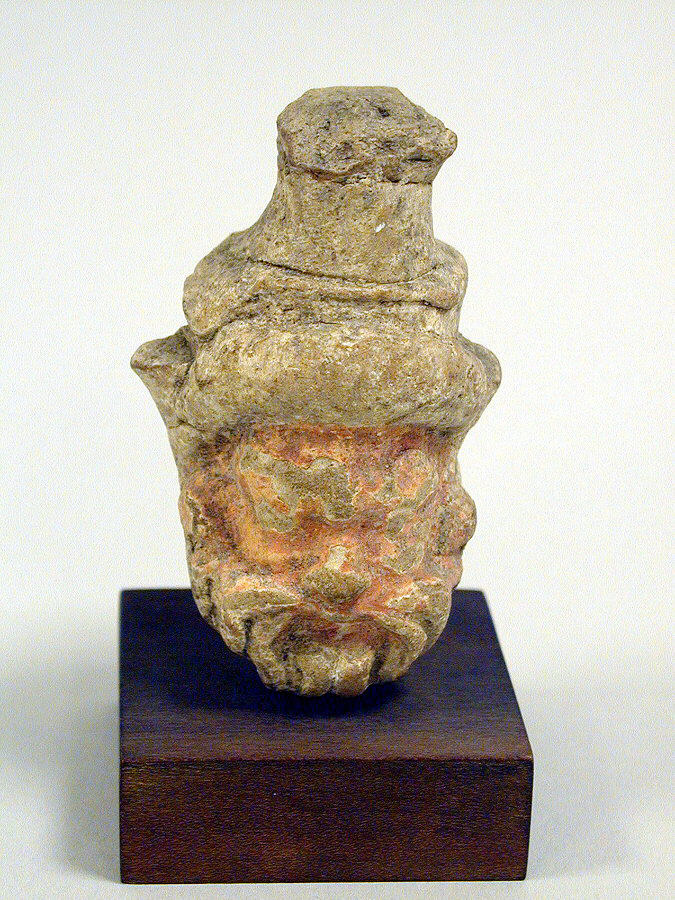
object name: head of a man, grotesque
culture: greek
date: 7000-30 BCE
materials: terracotta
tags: heads,men